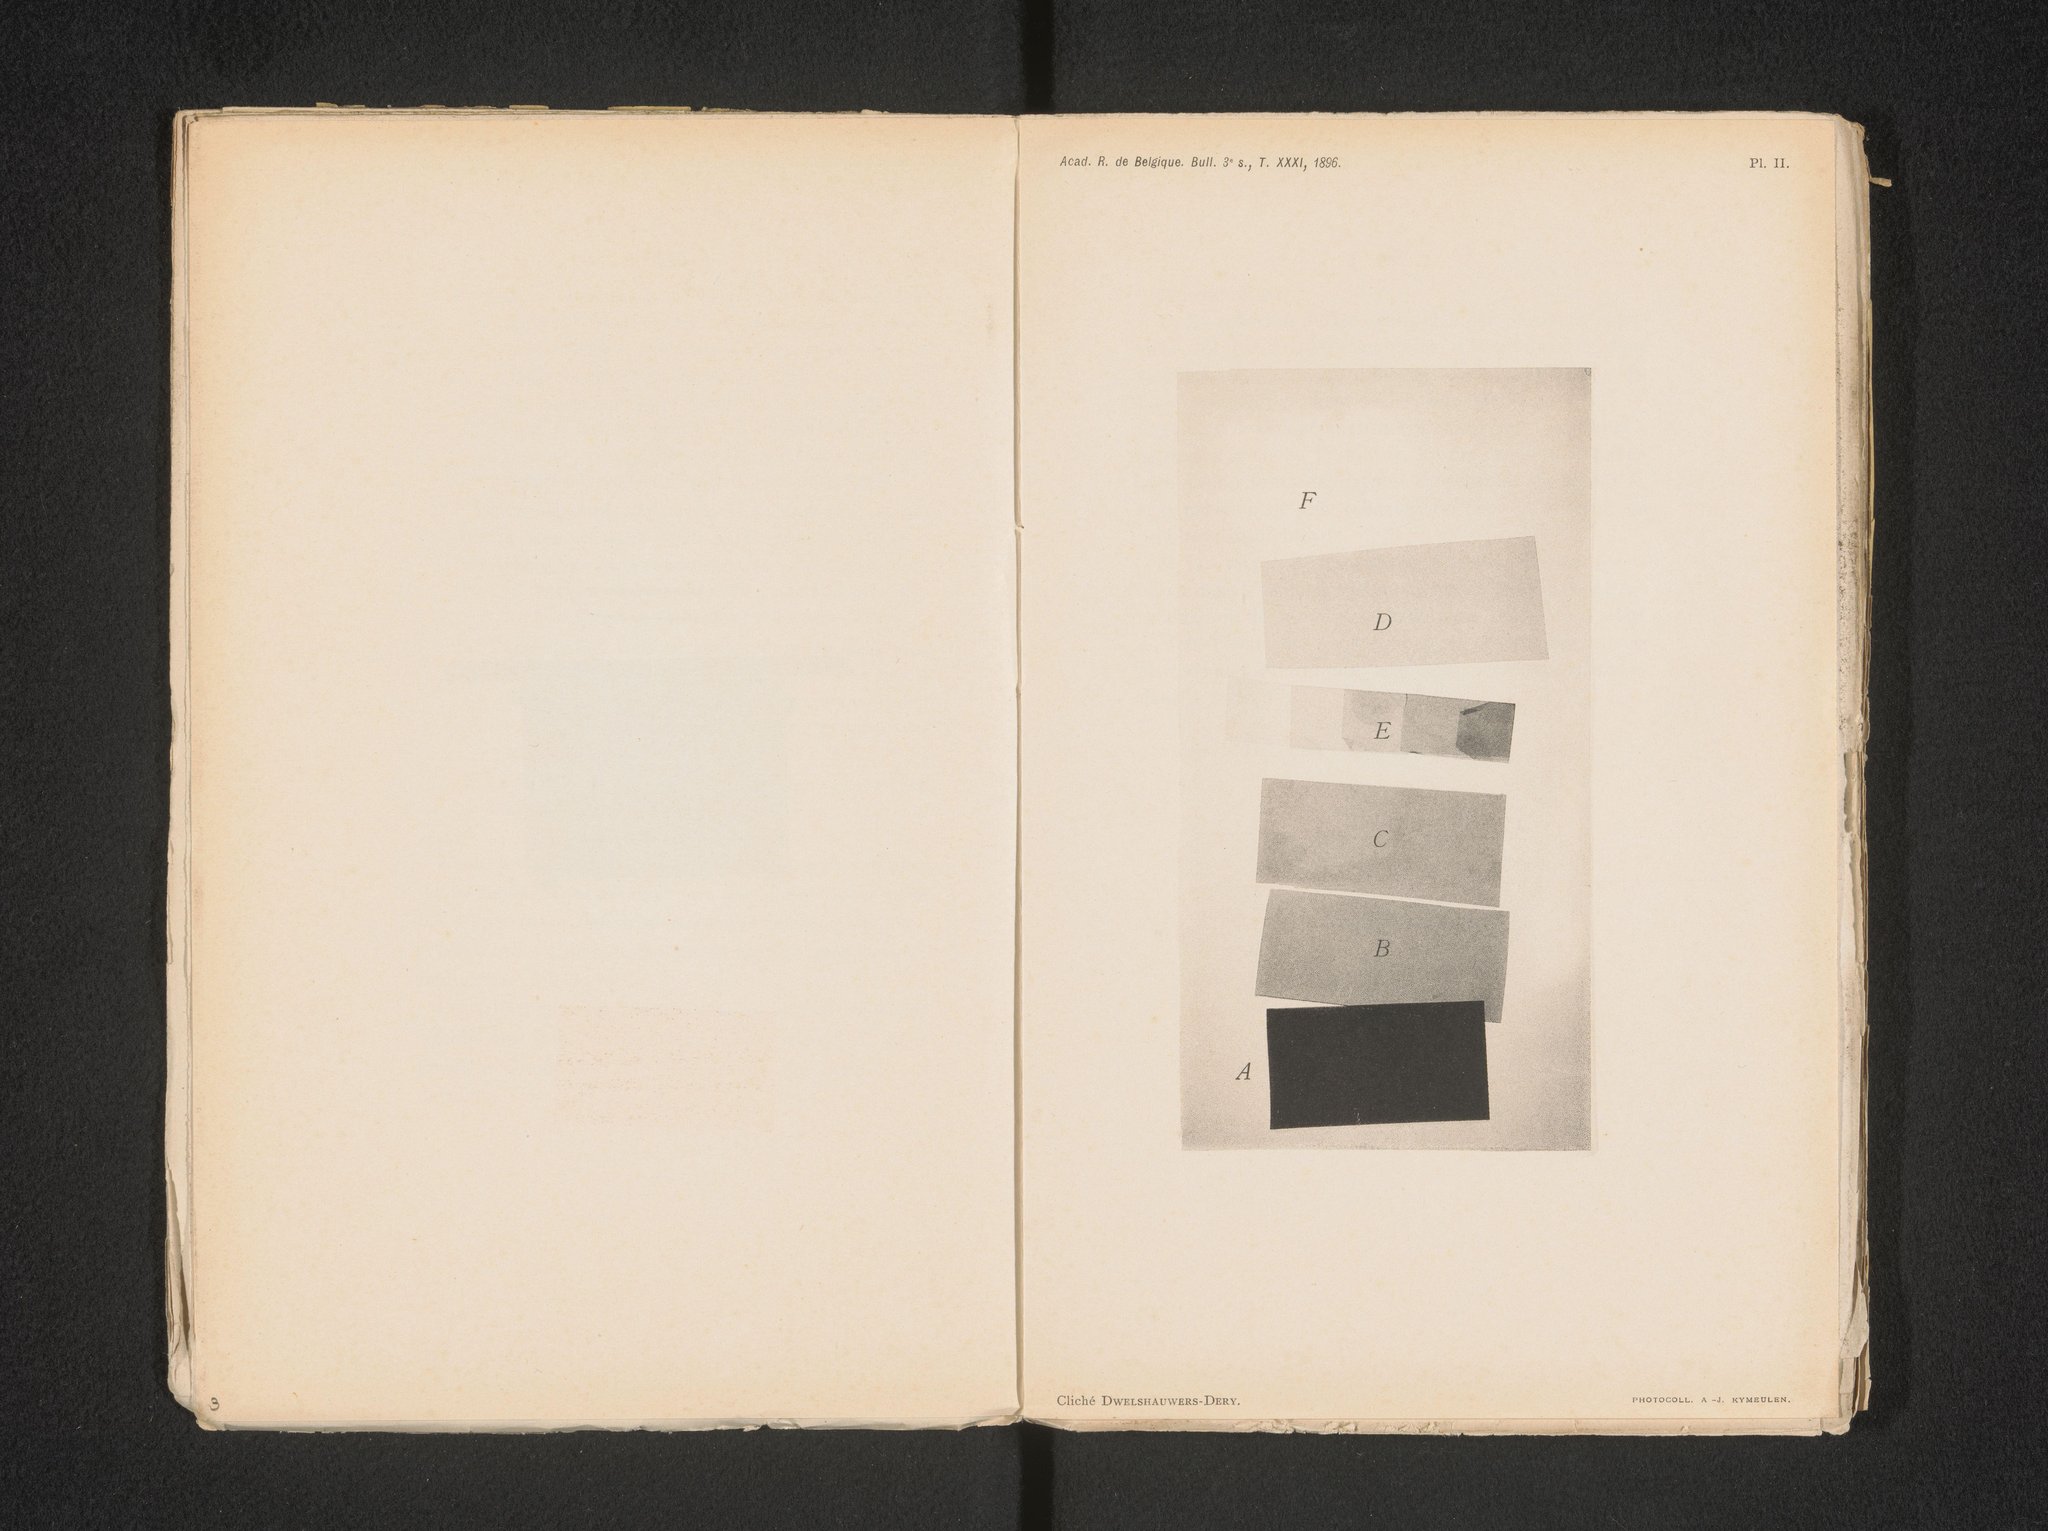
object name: page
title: Voorbeelden van de breking van licht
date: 1891-1896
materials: paper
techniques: photograph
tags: rays of natural light, reflection (light in general)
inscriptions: number: ‘Pl. II.’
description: Prent op derde ongenummerde pagina na pagina 486.